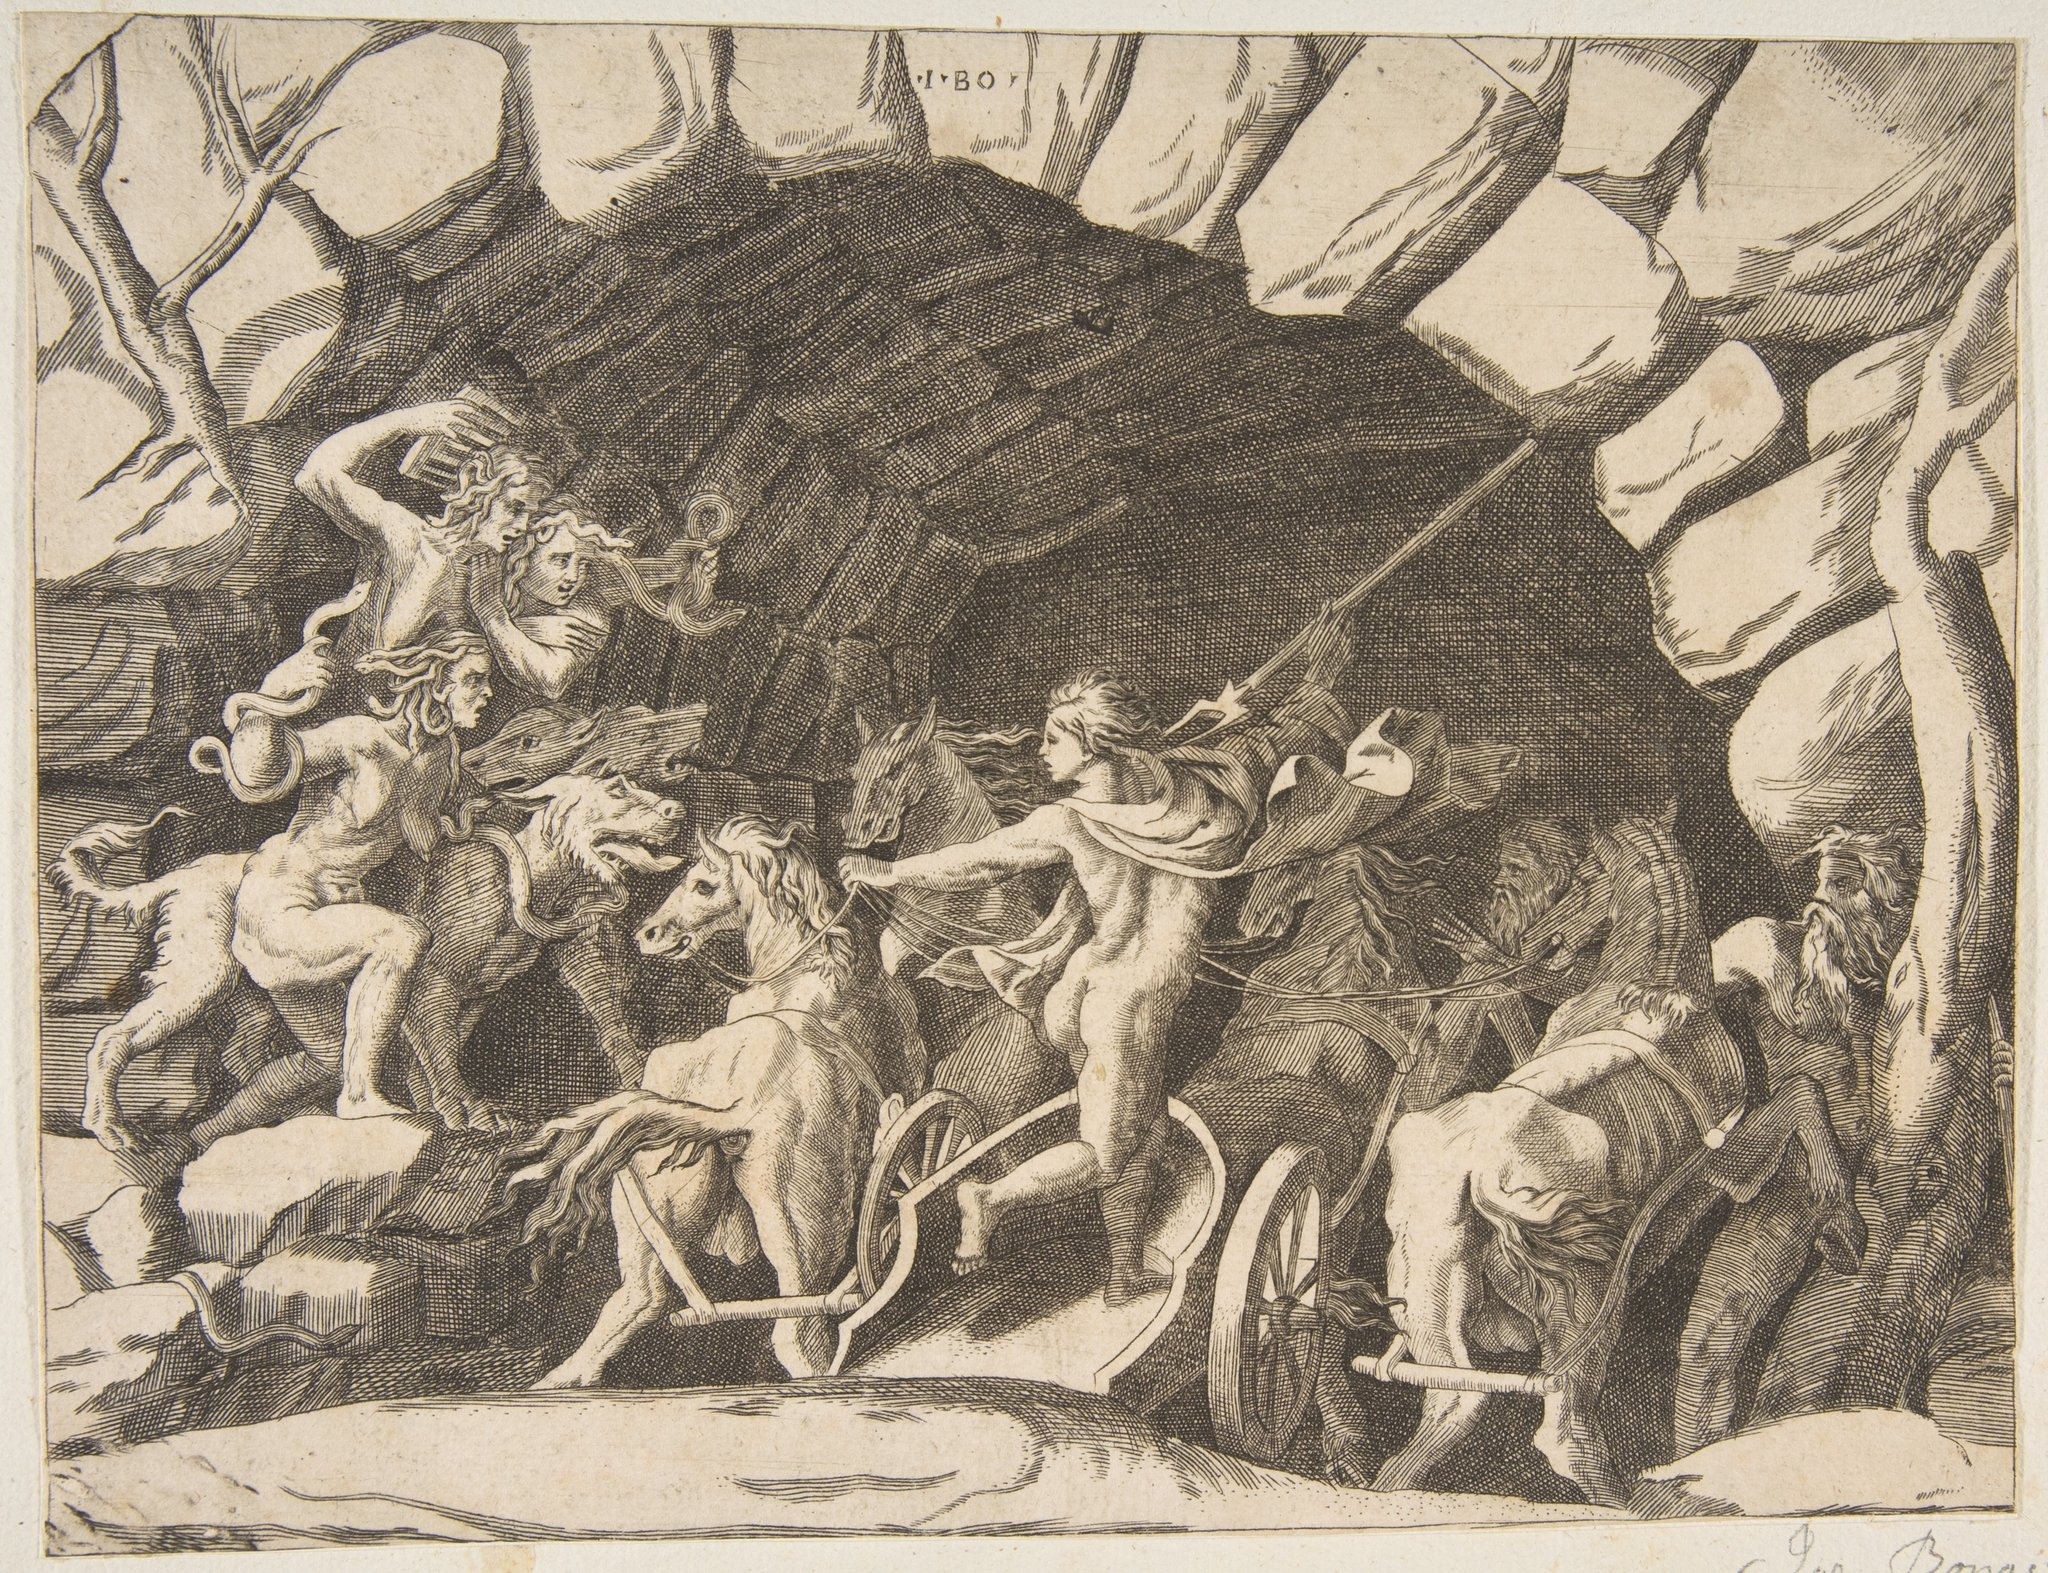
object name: print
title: Pluto riding a chariot descending into Hell, from "Division of the Universe"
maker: giulio bonasone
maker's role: artist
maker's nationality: italian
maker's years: 1510-1576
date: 1531-1576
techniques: engraving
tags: mythology,horses,hell,chariots,pluto